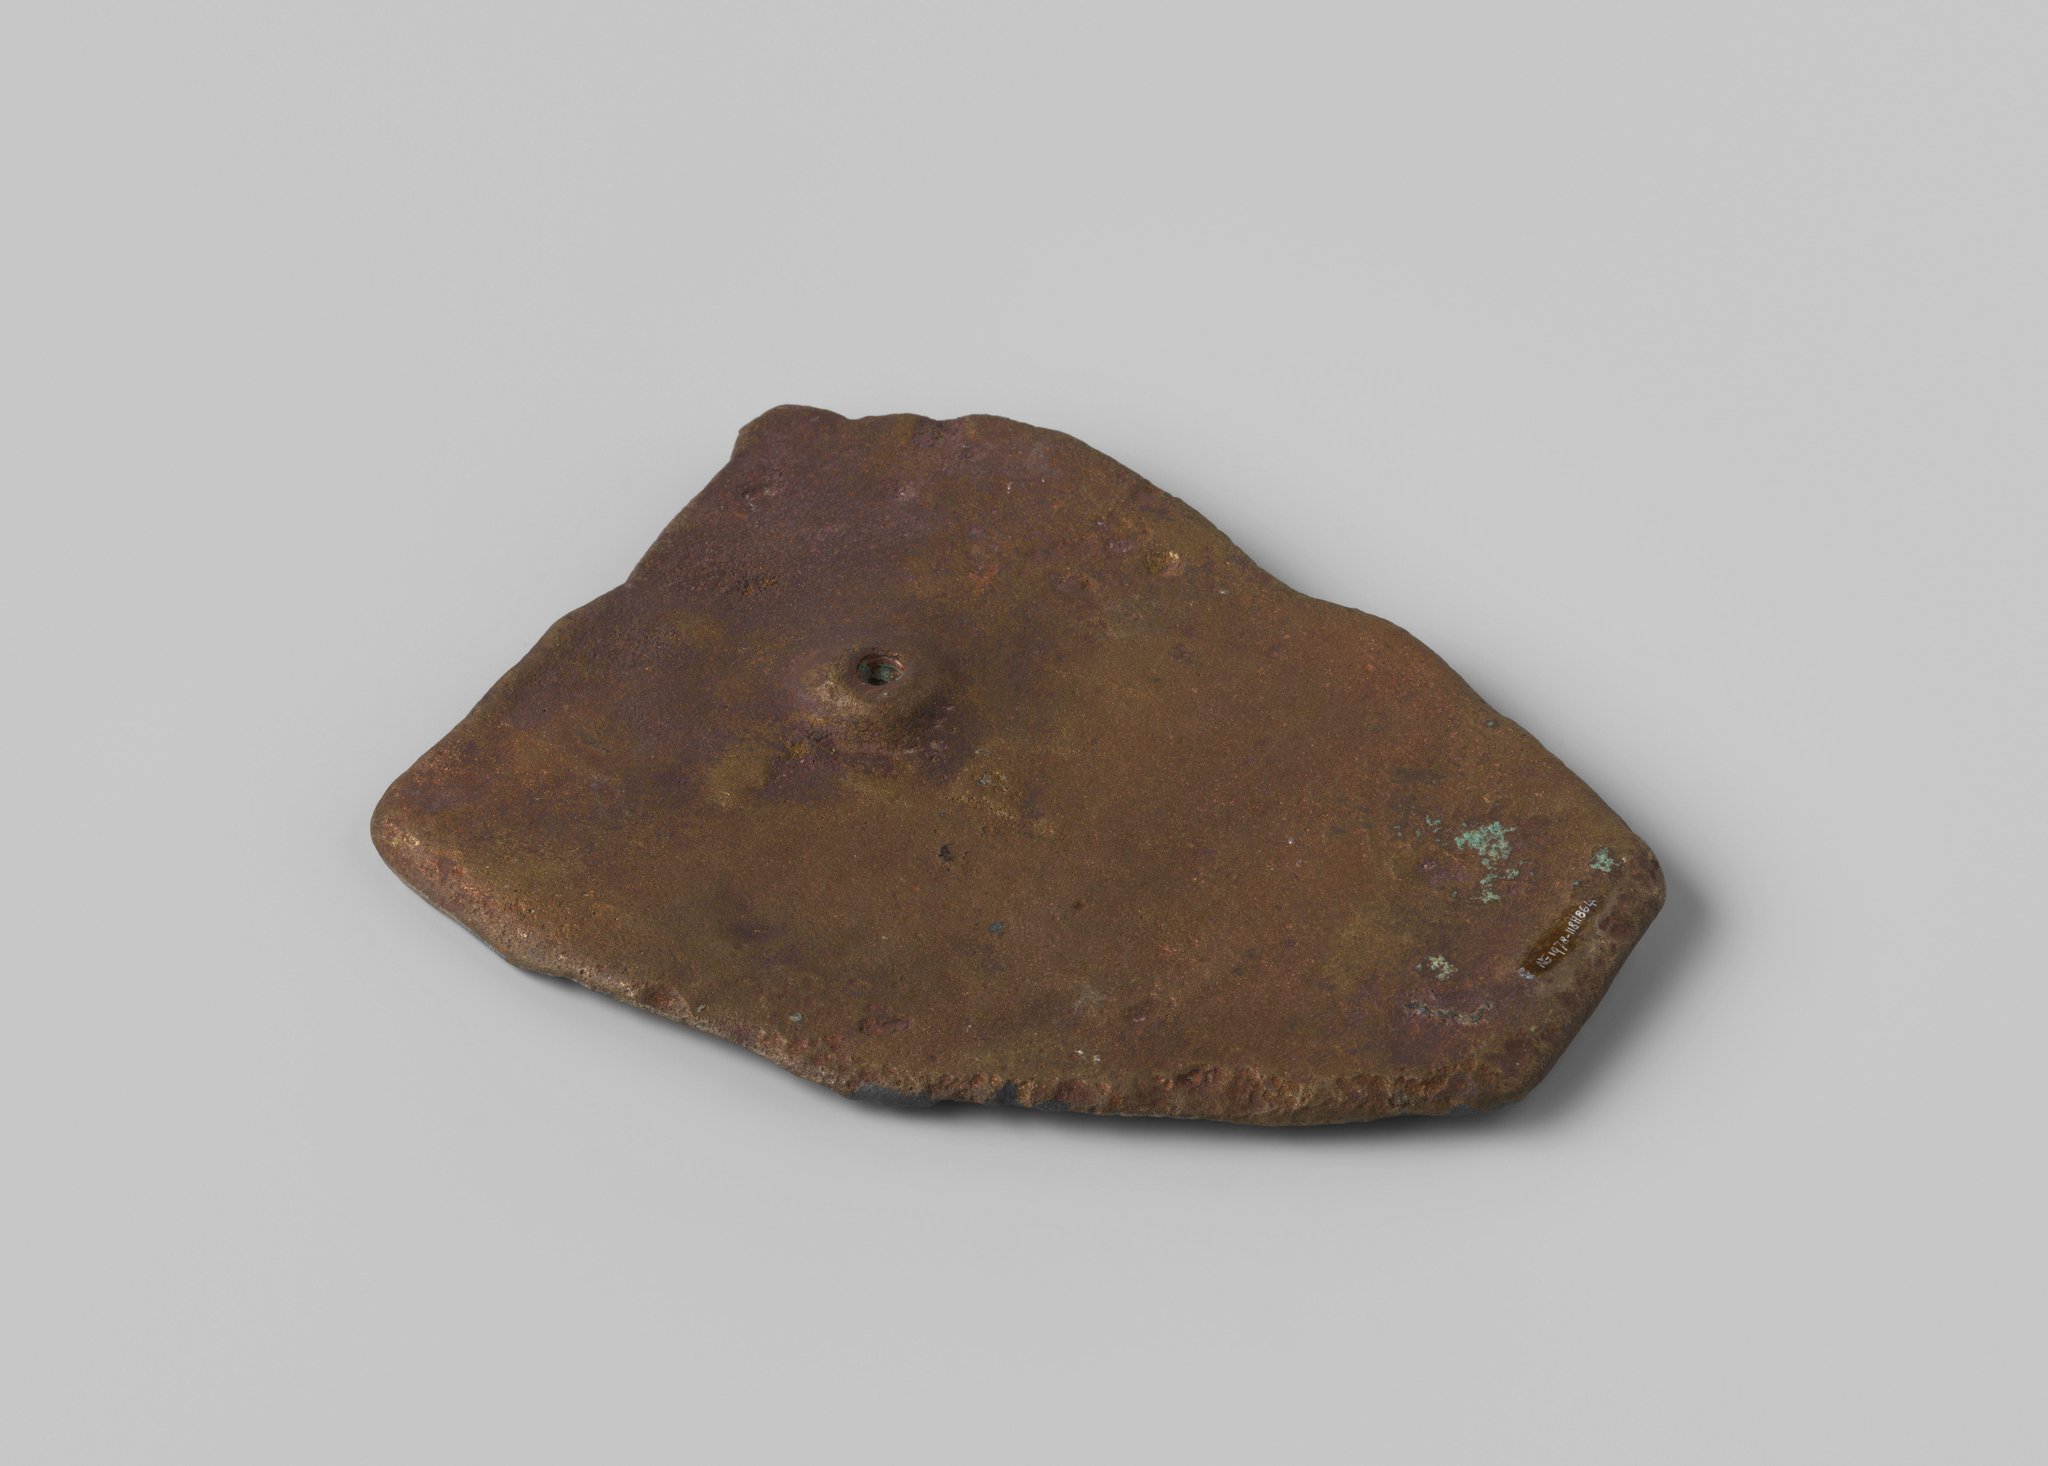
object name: flask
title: Gietmal uit het wrak van de Oost-Indiëvaarder Hollandia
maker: Anonymous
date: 1700-1743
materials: copper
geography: netherlands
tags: verenigde oostindische compagnie, hollandia (schip), annet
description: Tools and instruments, lead casting, mould; countermould of mould NG-1979-164-H-2673, eroded, on the reverse handle fitting and inscription id. NG-1979-192-H-3074.